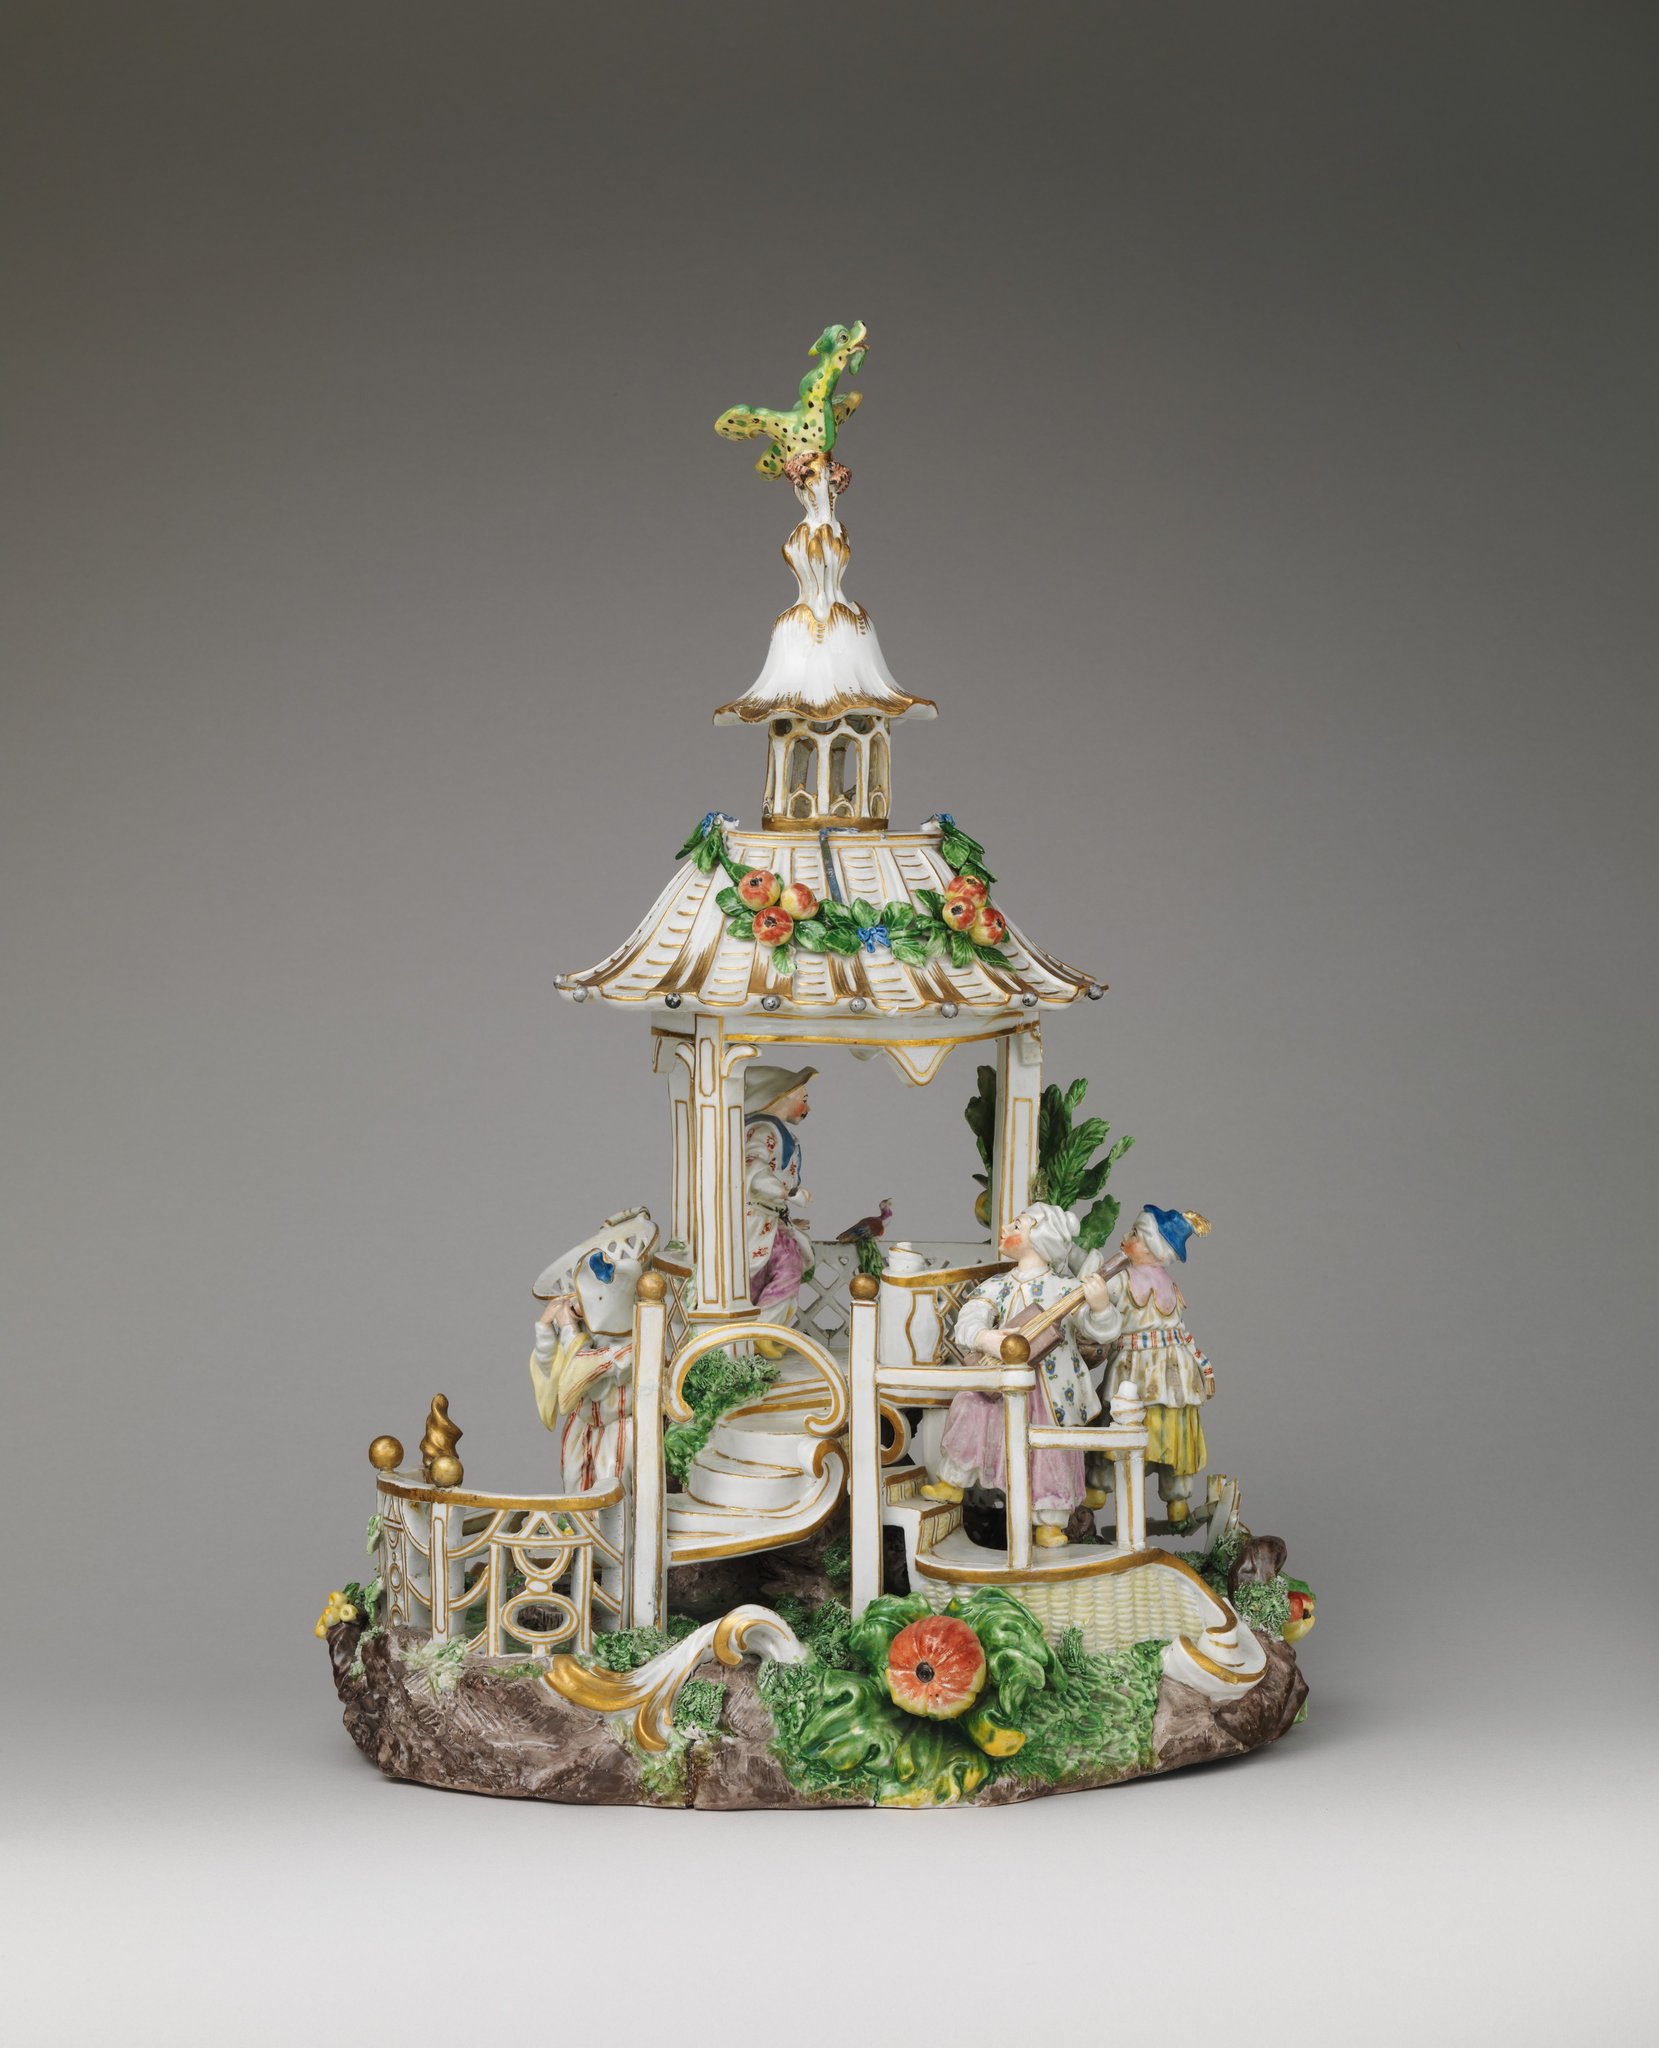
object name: figure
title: Chinese Pavilion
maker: frankenthal porcelain manufactory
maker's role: manufactory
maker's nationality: german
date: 1770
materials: hard paste porcelain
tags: fruit,men,women,leaves